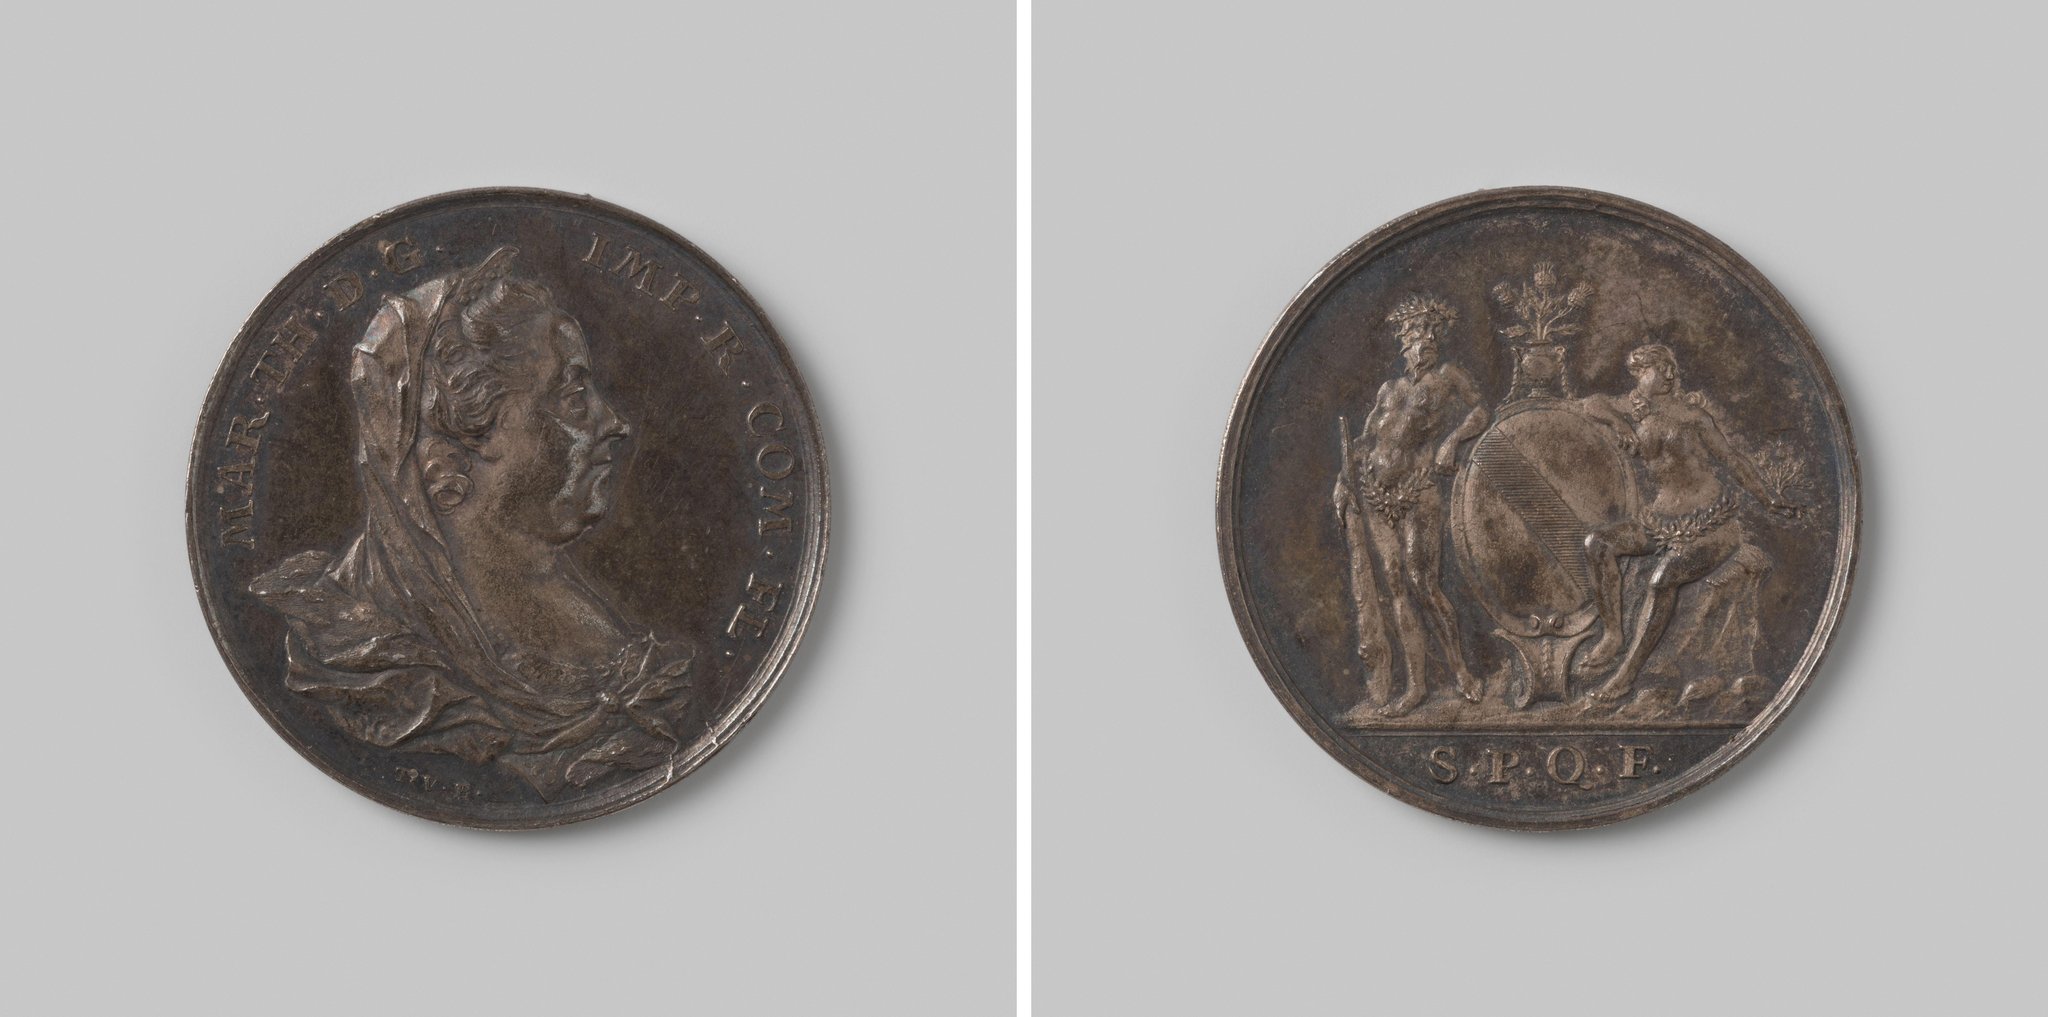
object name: history medal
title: Het Vrije van Brugge 1776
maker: theodorus victor van berckel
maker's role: mintmaster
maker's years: 1739-1808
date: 1776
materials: silver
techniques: striking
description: Zilveren penning, op de voorzijde het gesluierde portret van Maria Theresia met omschrift, op de keerzijde een ovaal wapenschild van het Vrije tussen een staande wildeman en een zittende vrouw, in afsnede SPQF.